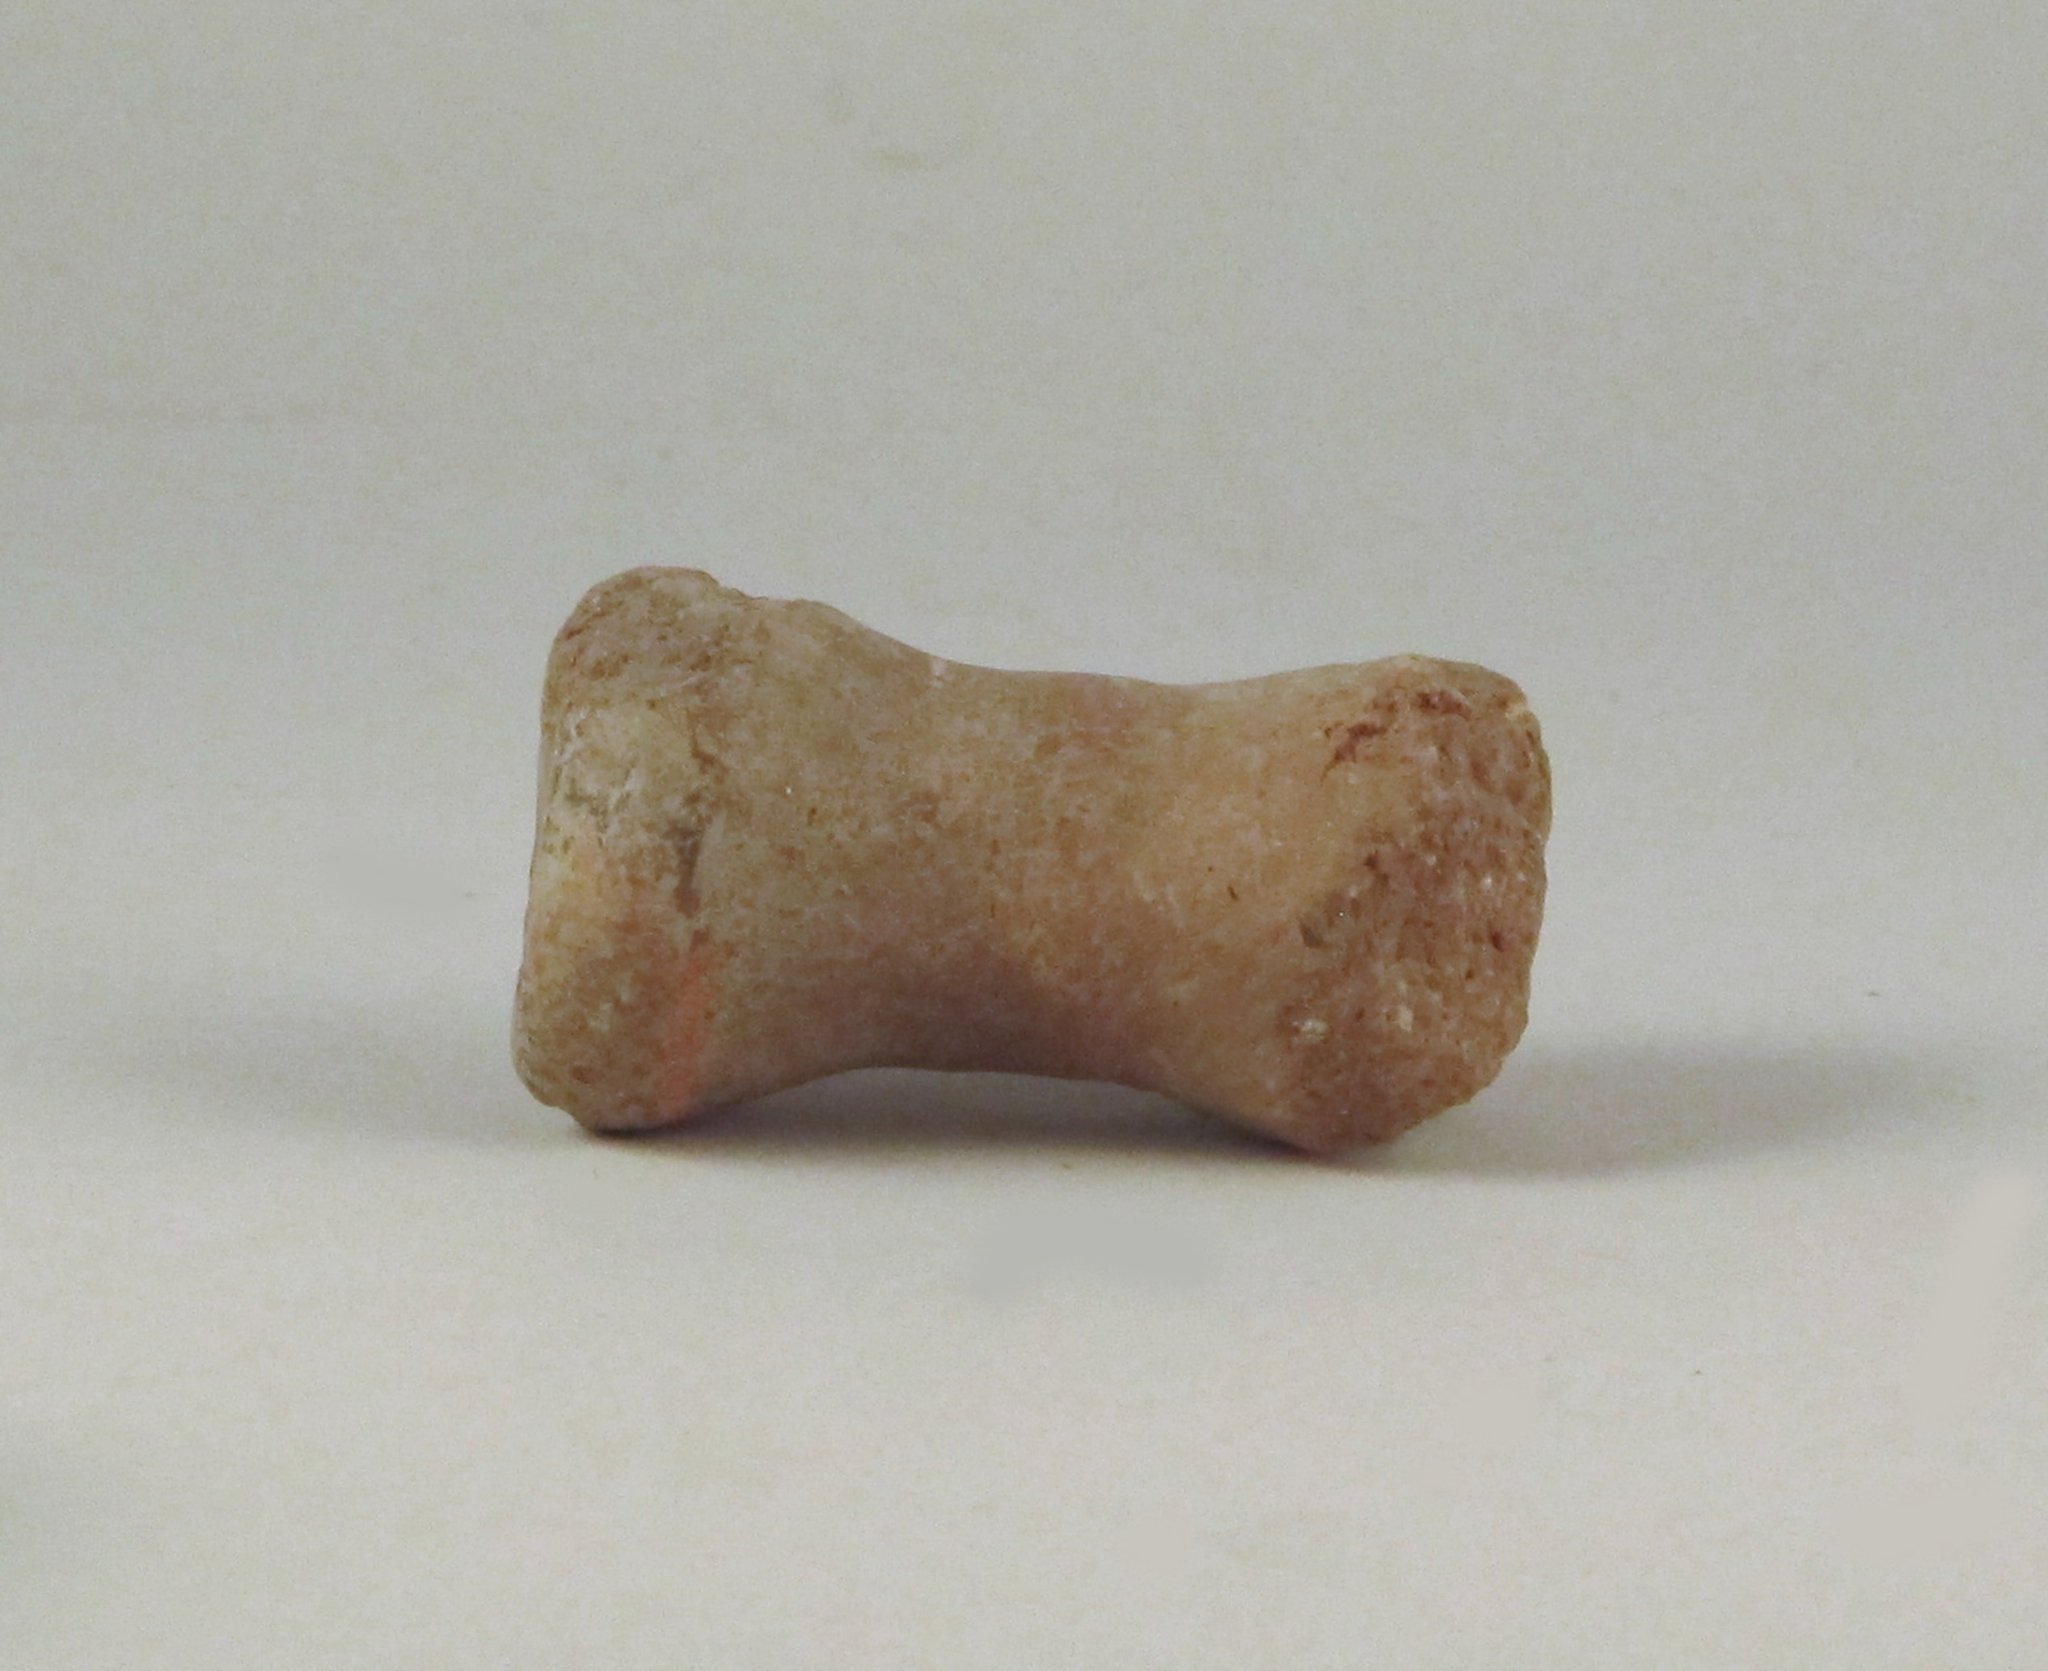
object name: spindle whorl, reel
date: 7000 BCE-330 CE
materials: clay